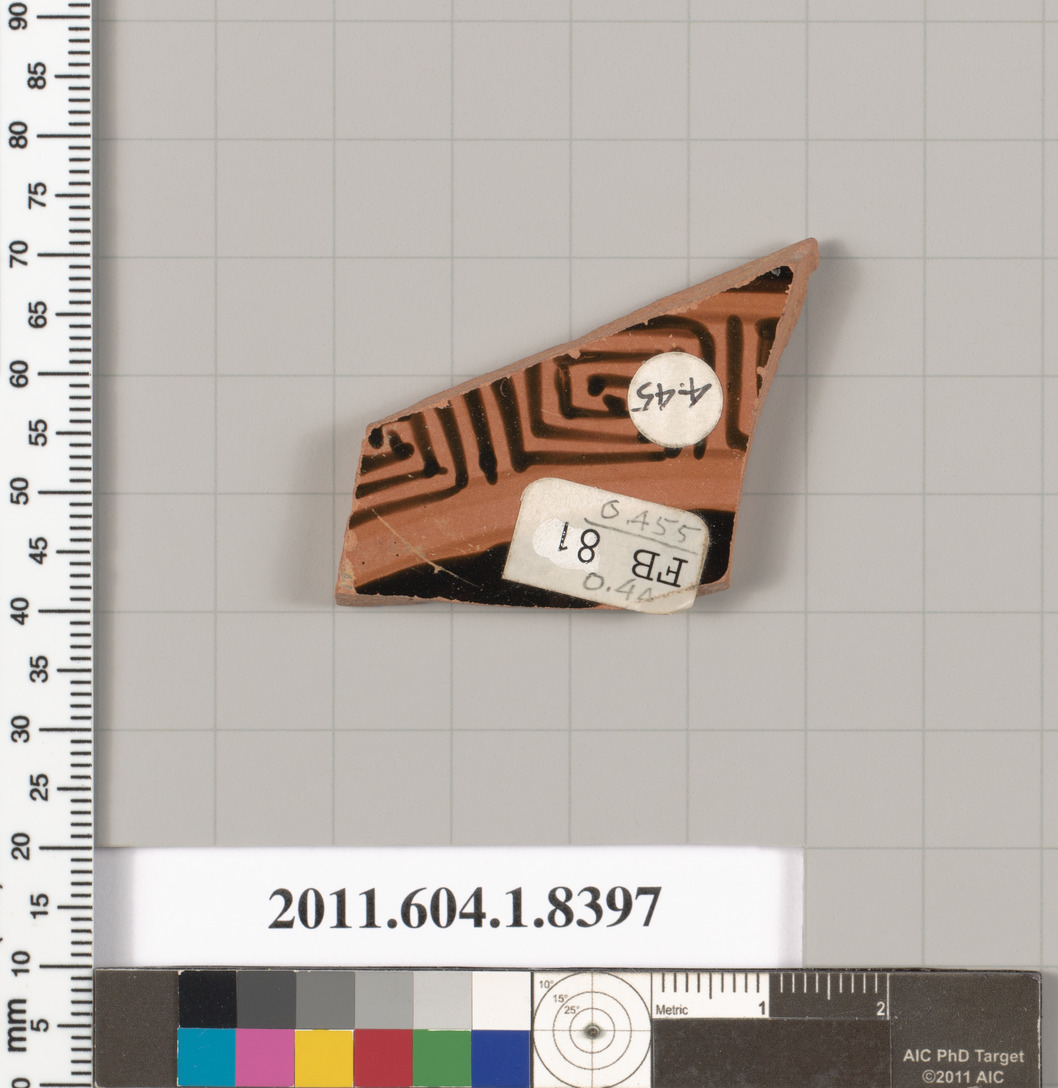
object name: kylix fragment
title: Terracotta fragment of a kylix (drinking cup)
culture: greek, attic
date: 400-376 BCE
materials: terracotta